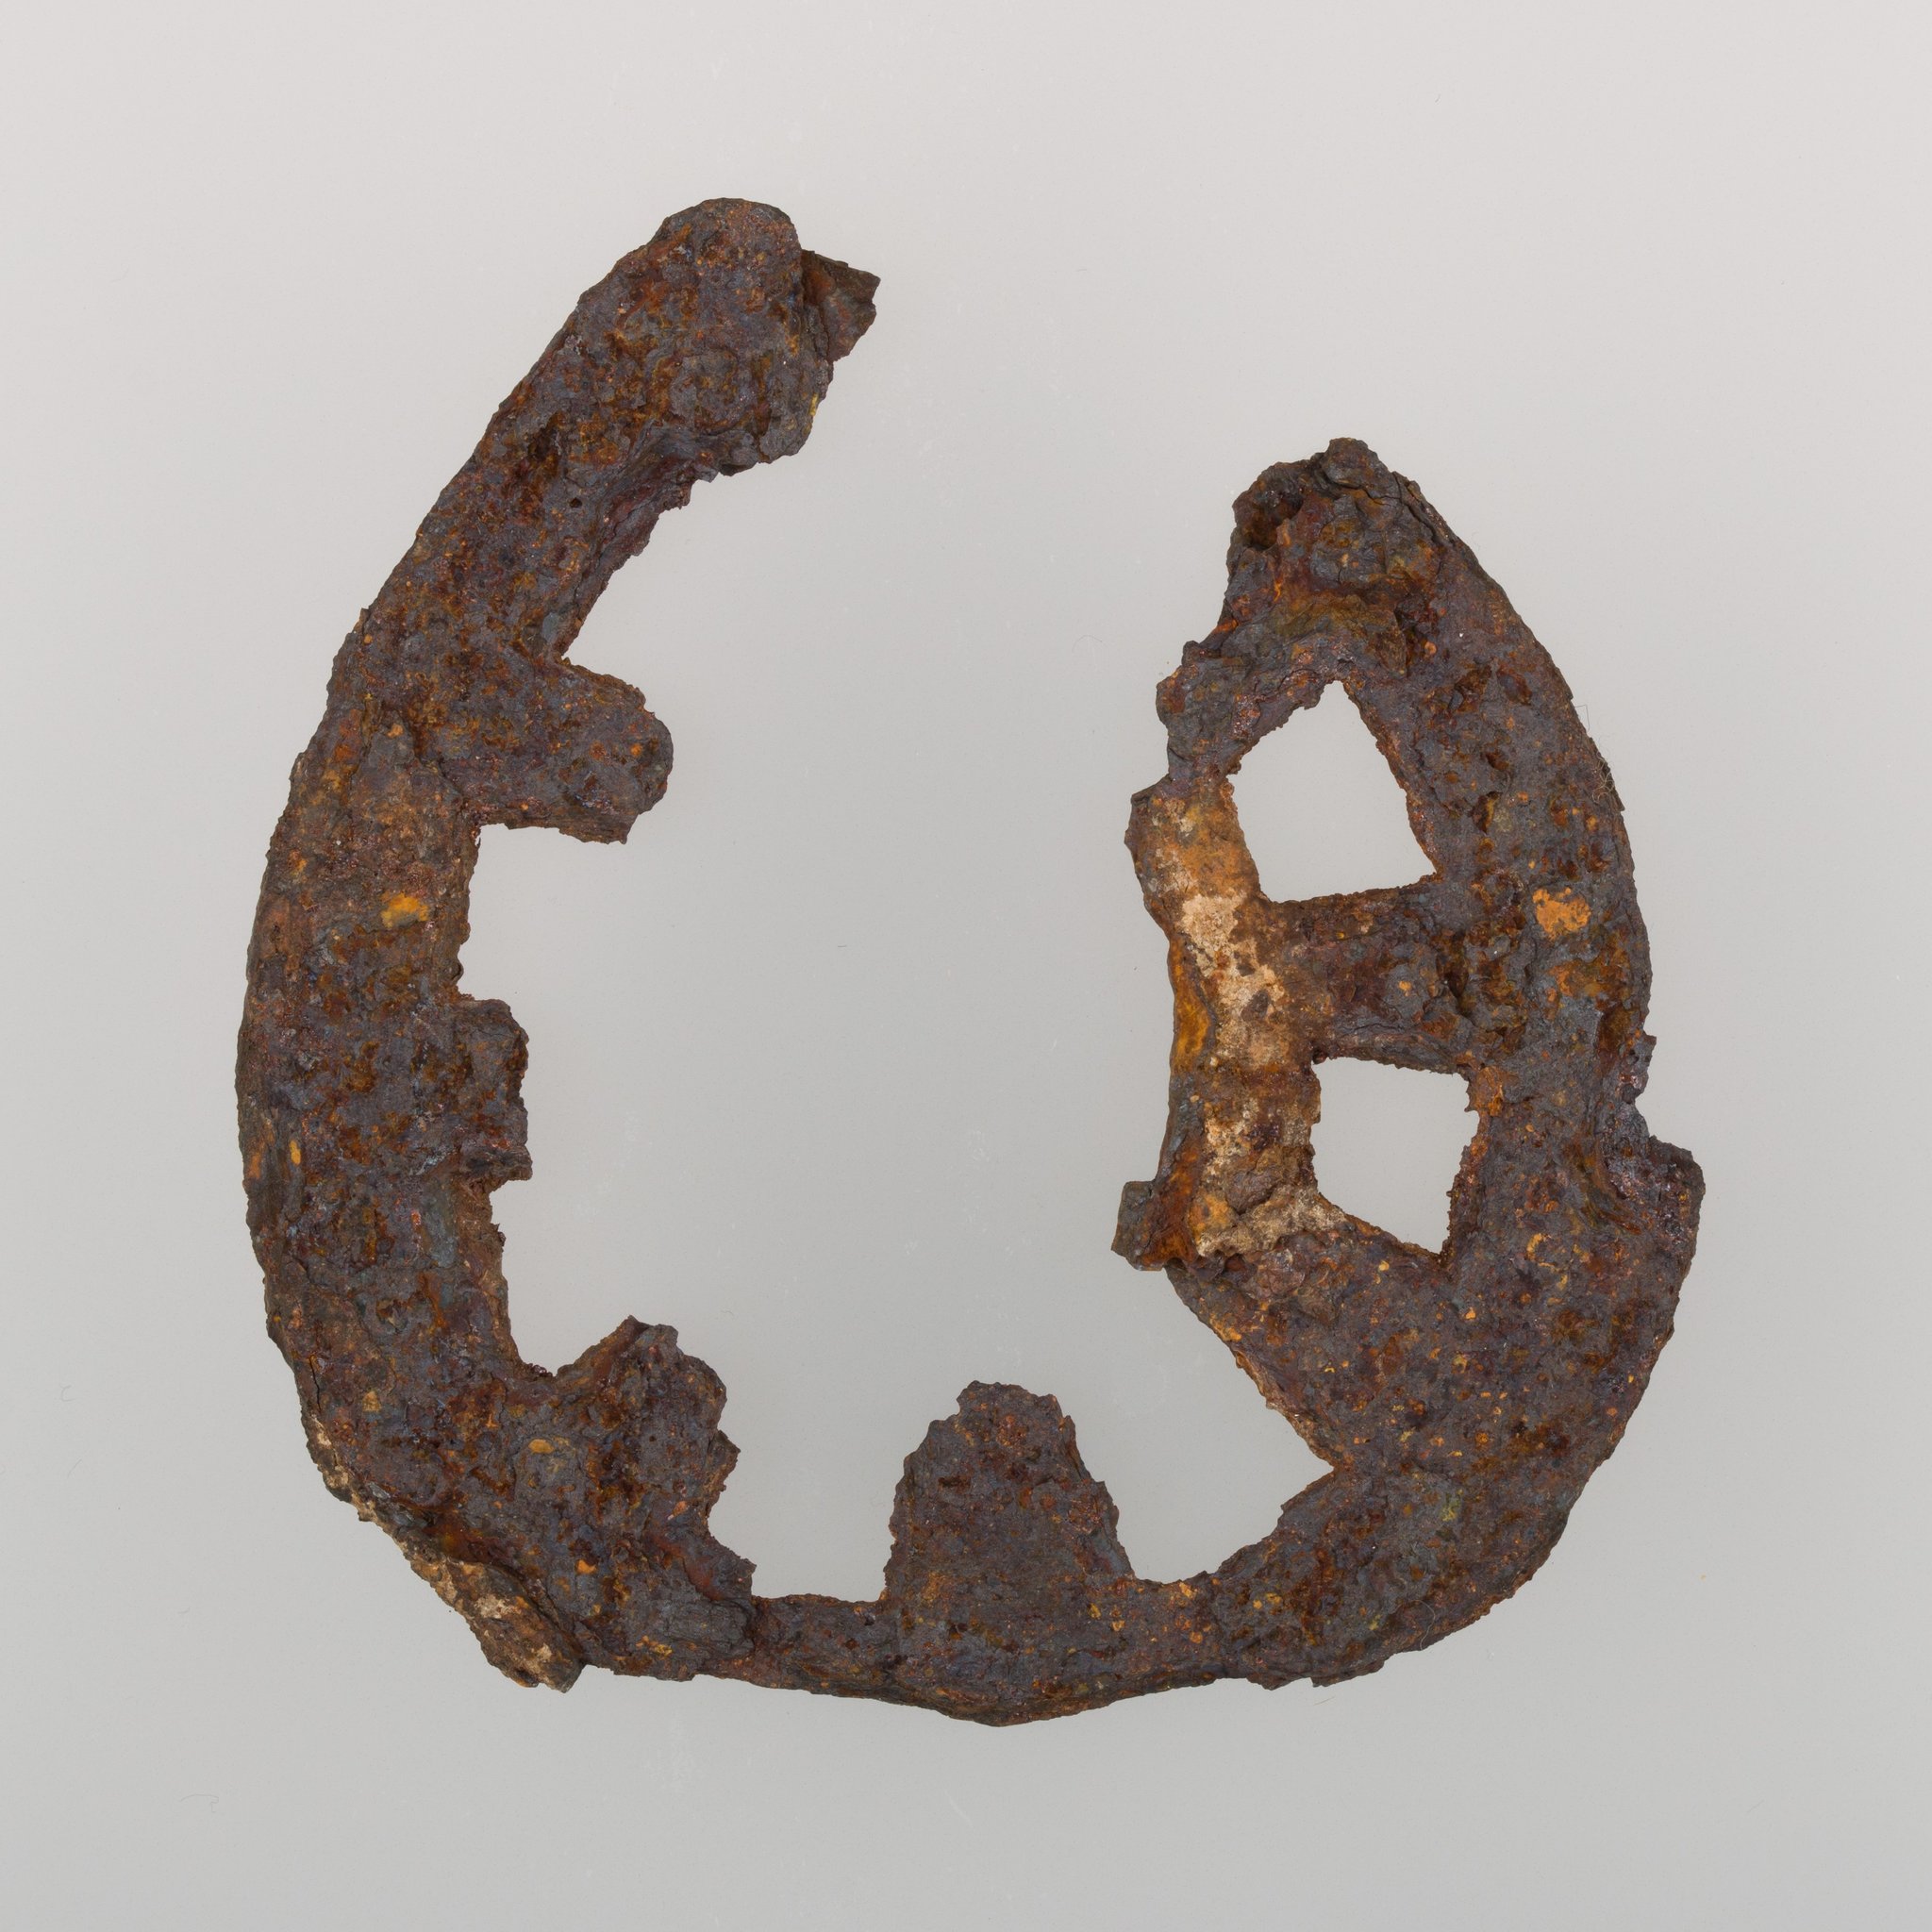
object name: sword guard tsuba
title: Sword Guard (Tsuba)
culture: japanese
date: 201-300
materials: iron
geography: japan